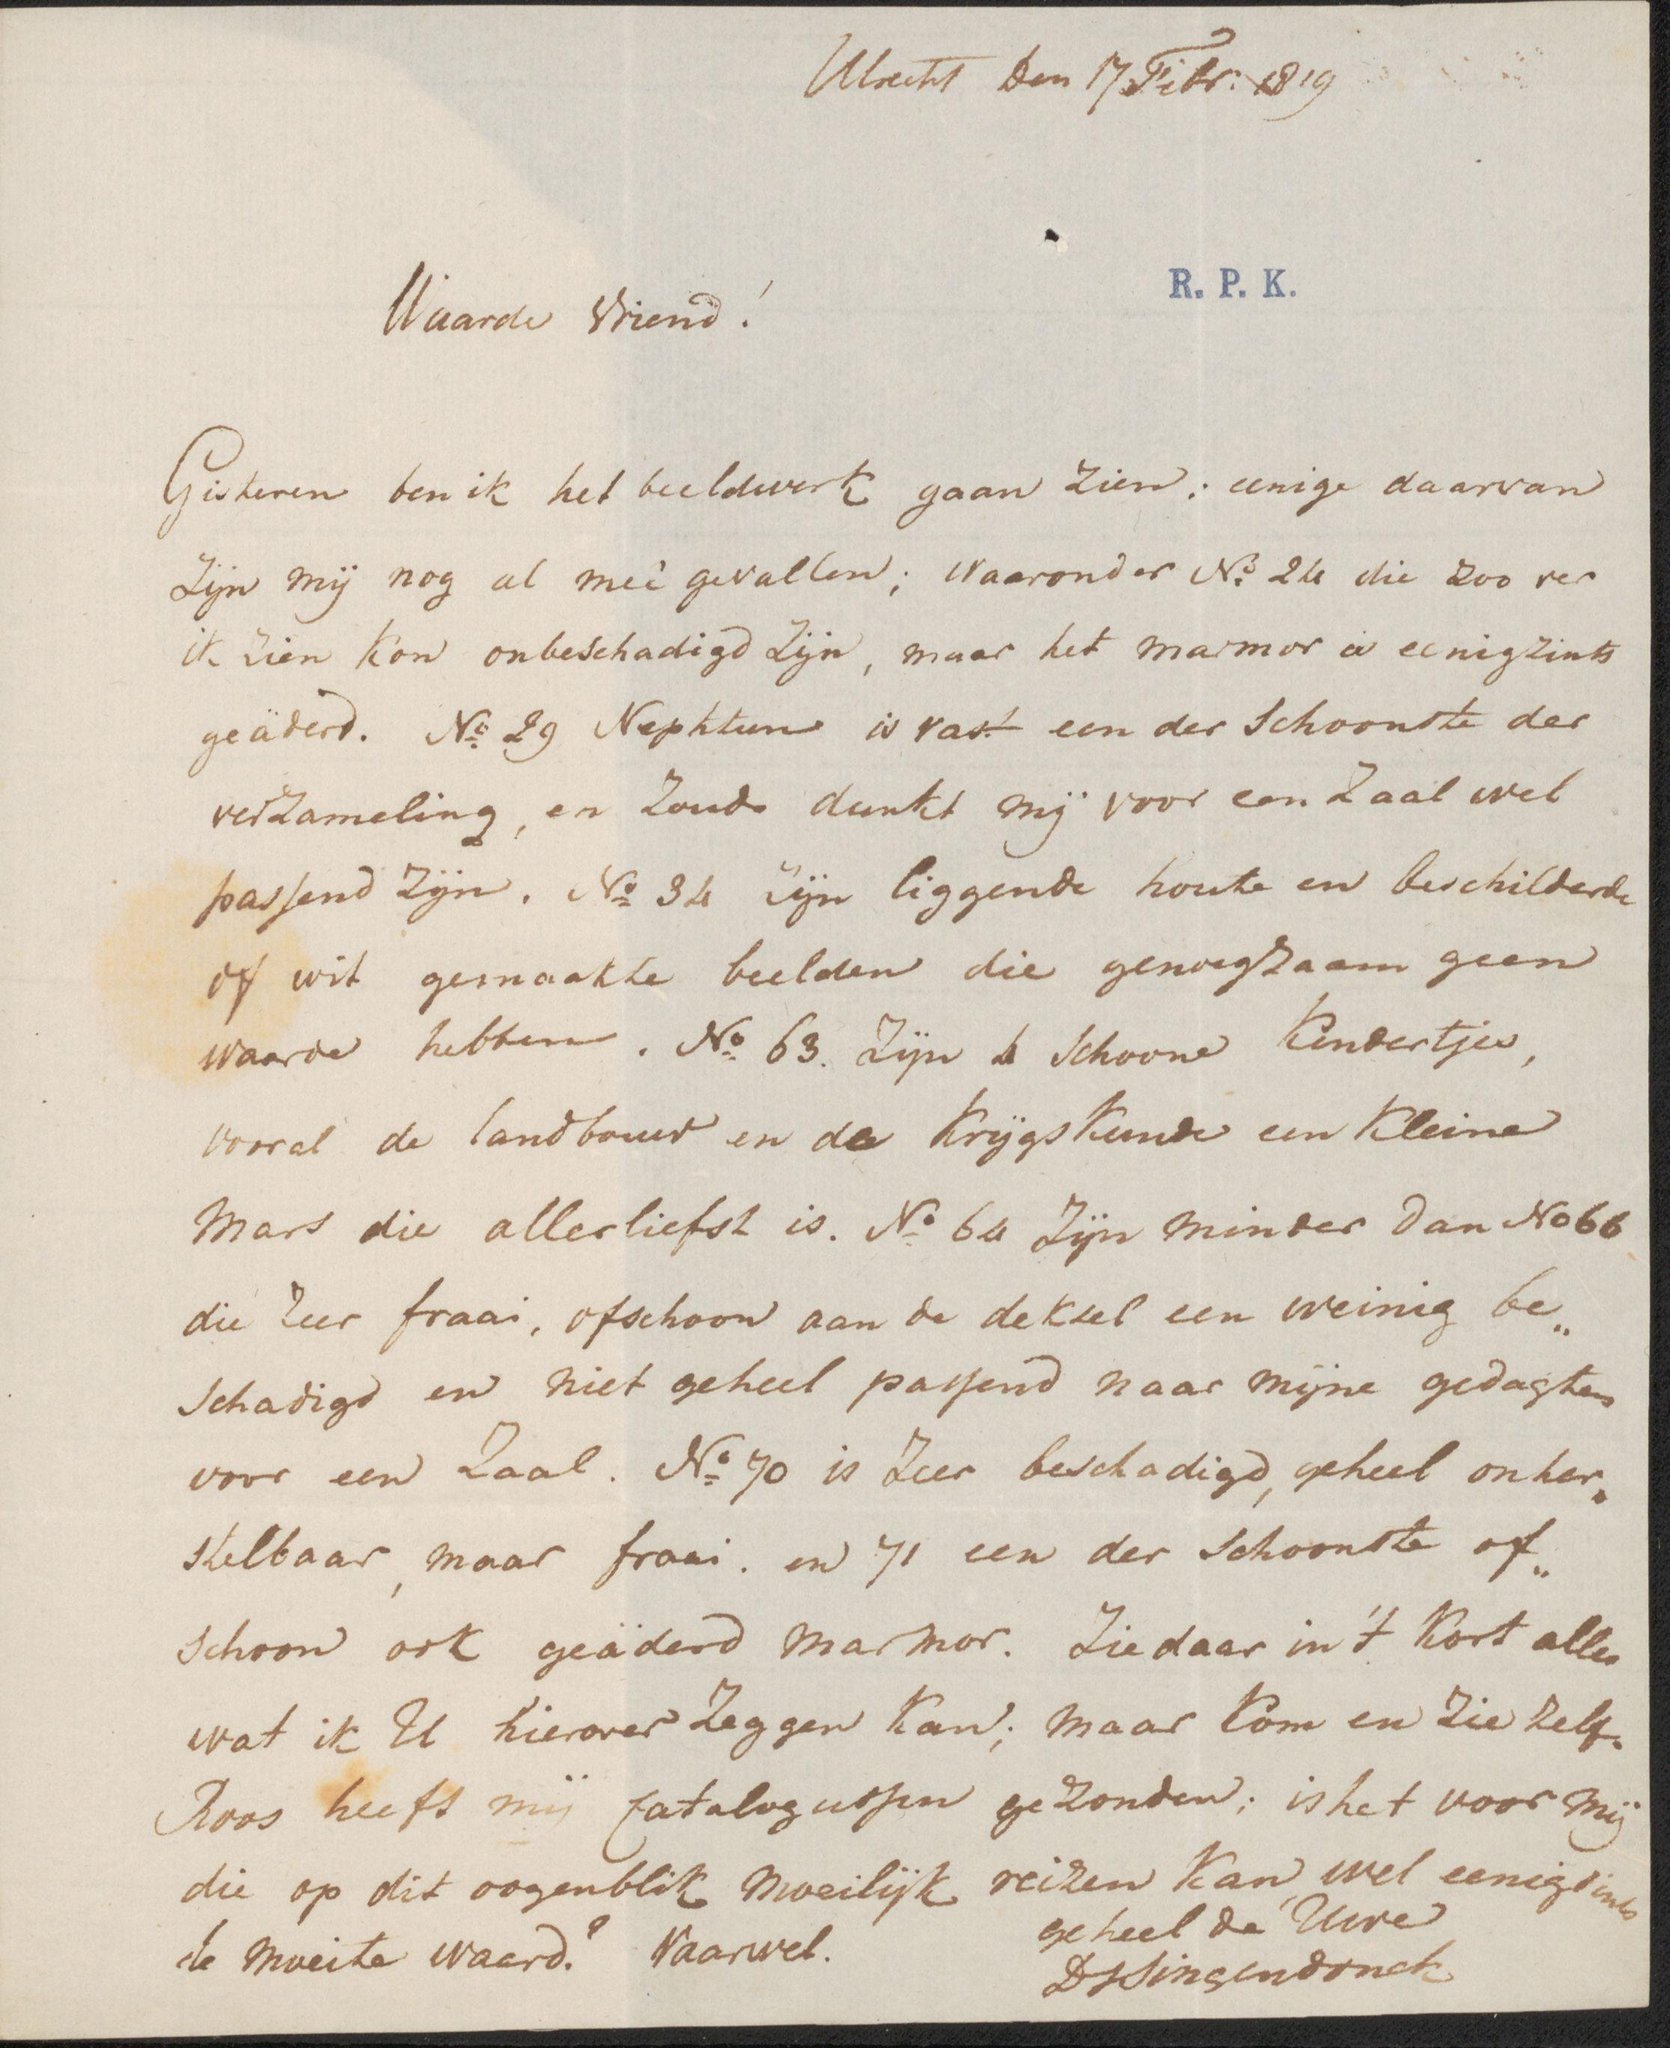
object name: letter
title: Brief aan anoniem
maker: diederik jan singendonck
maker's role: print maker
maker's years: 1784-1833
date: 1819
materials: ink, paper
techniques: pen, writing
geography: utrecht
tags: sculpture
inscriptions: collector's mark: Lugt 2233, watermark